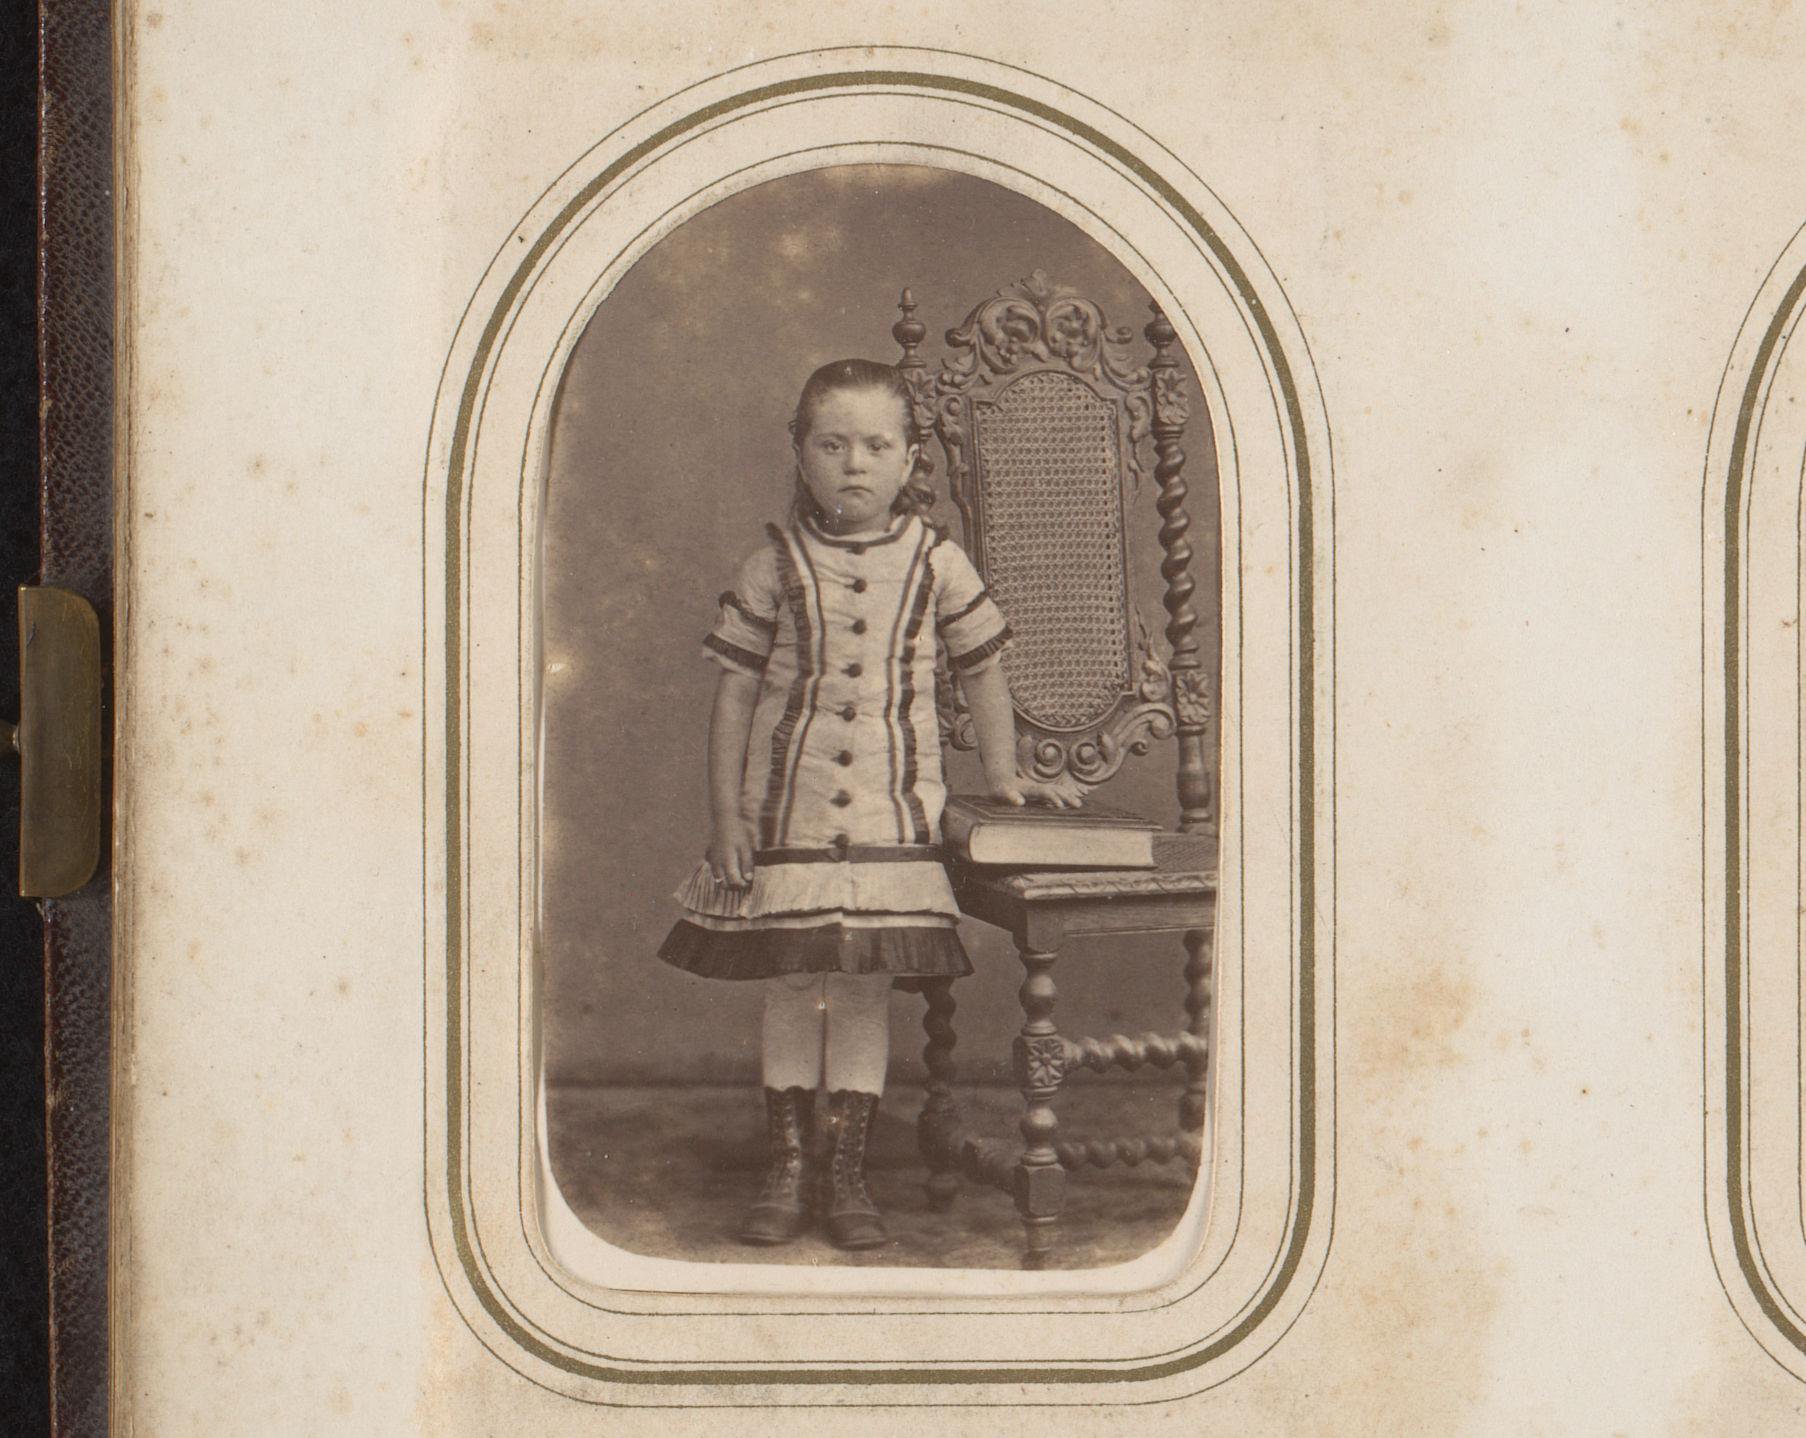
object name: album leaf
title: Portret van een meisje, staand bij een stoel met boek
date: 1873-1883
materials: cardboard, celluloid, photographic support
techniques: albumen print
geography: hoorn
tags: historical persons - bb - woman, book, standing figure - aa - female human figure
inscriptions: inscription: ‘HUIJSSEN en ZOON/ Photographen/ HOORN’